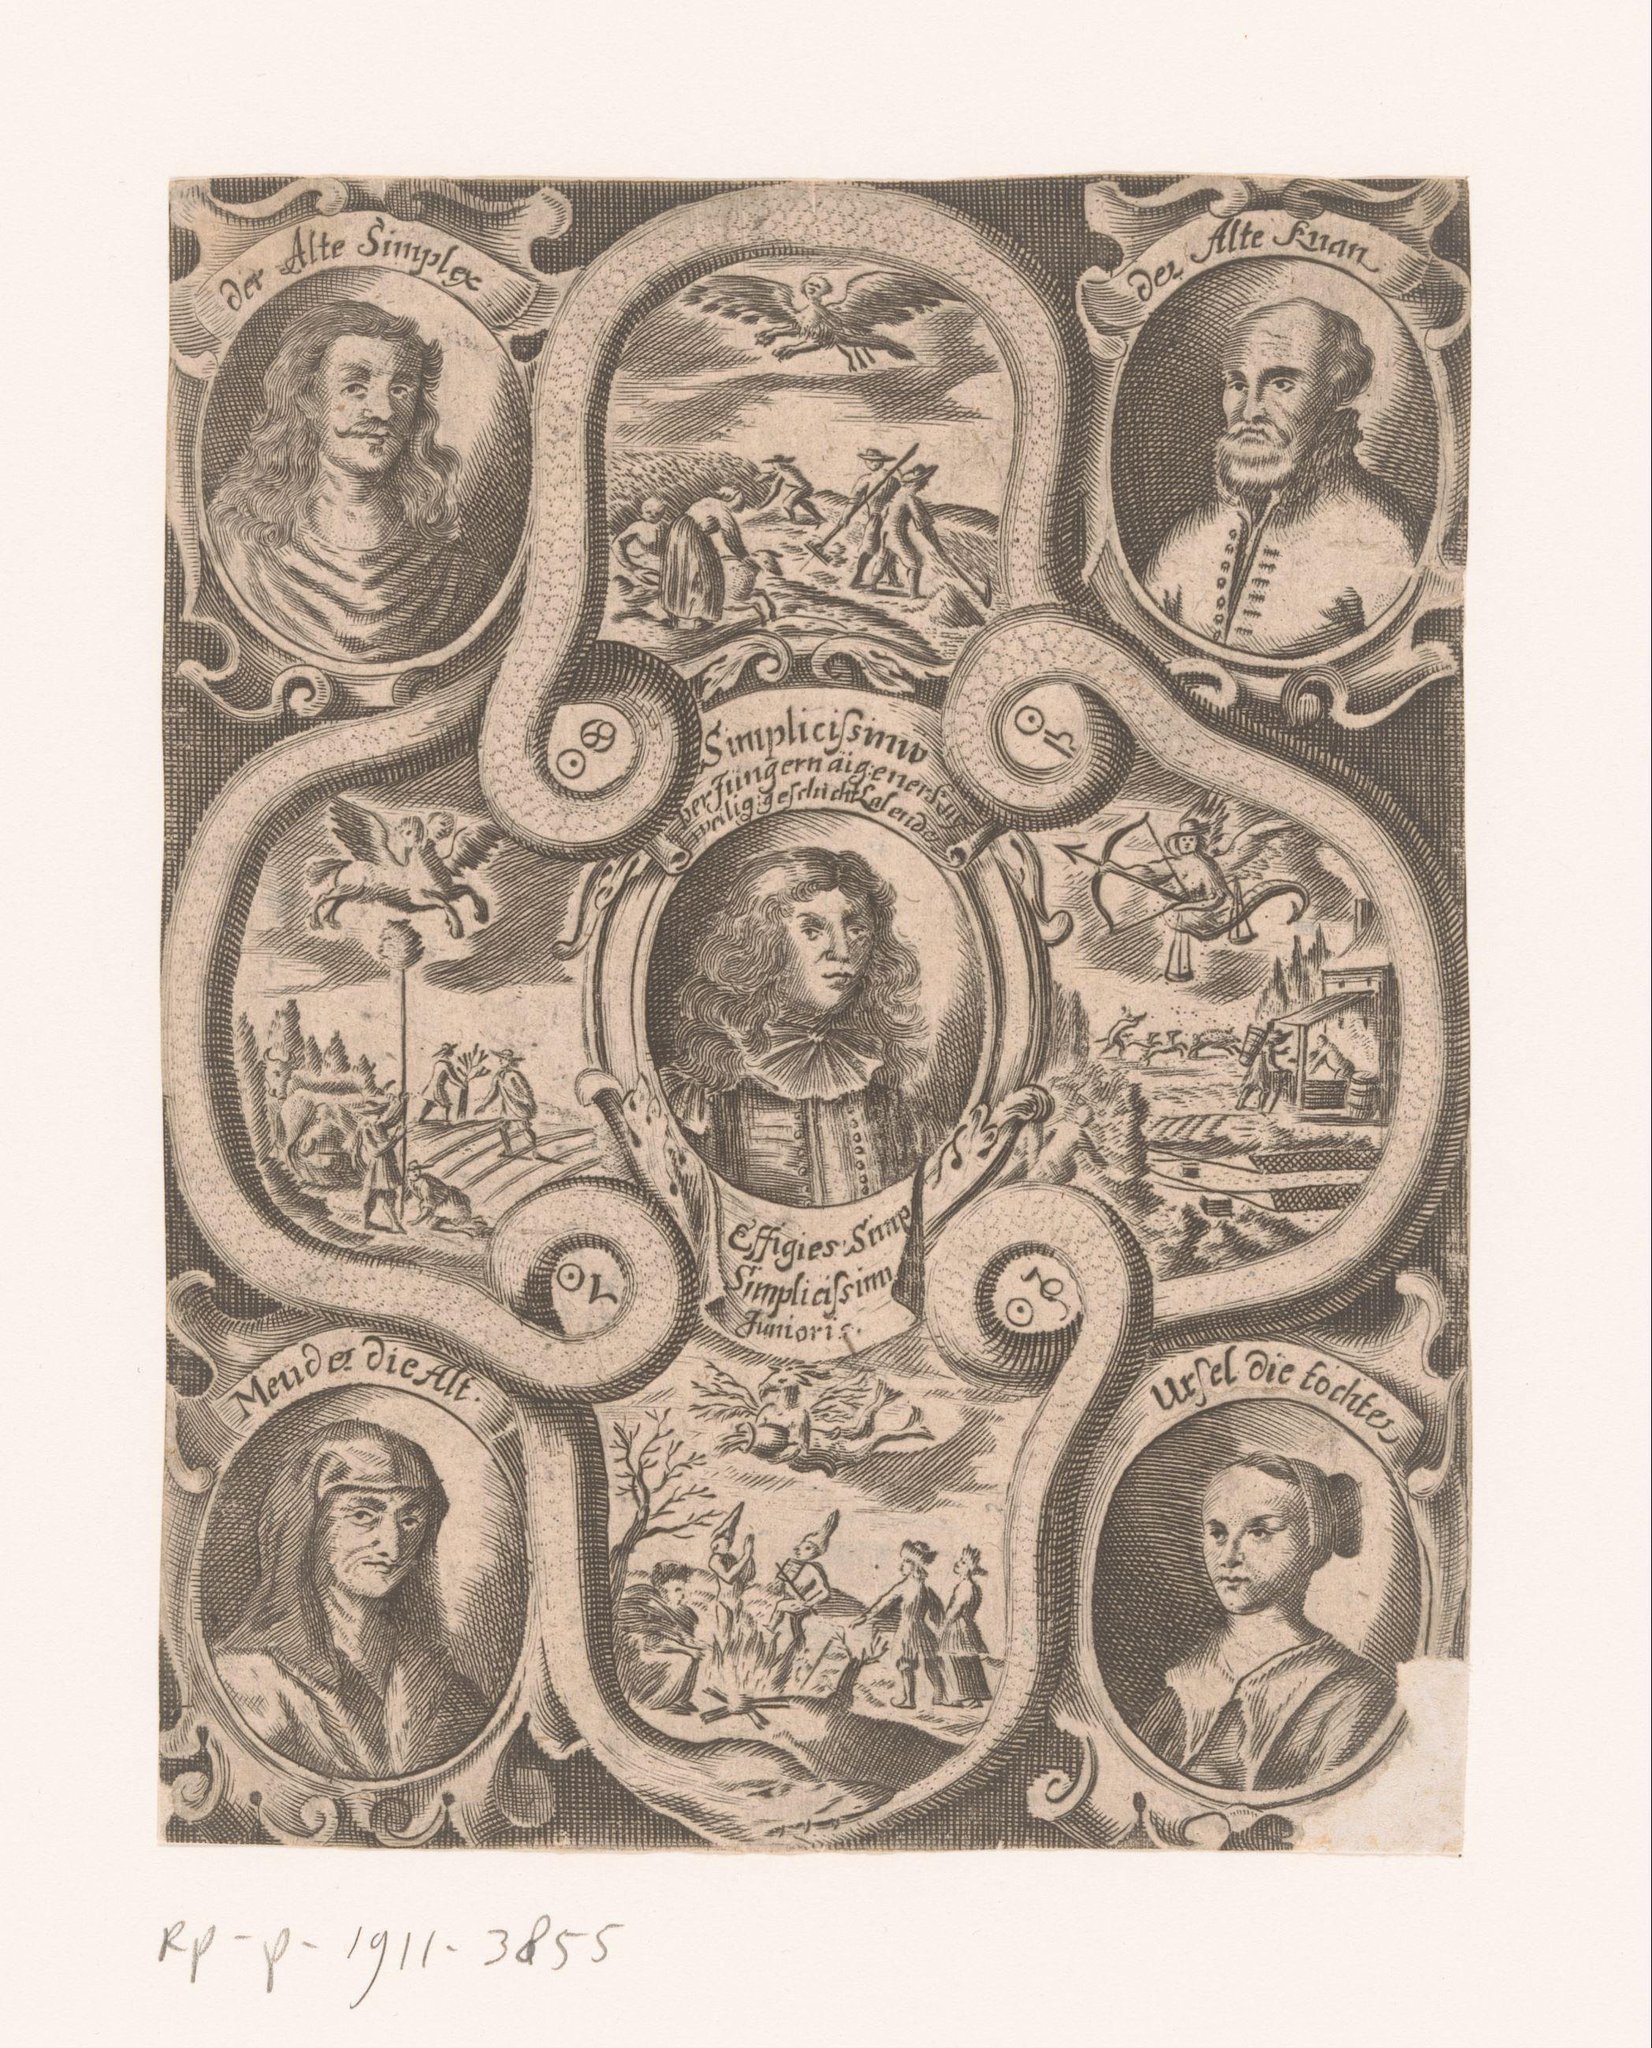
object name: print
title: Portret van een onbekende familie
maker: Anonymous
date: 1600-1699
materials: paper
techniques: etching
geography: germany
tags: historical persons, abstract ideas and concepts (+ emblematical representation of concept)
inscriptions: collector's mark: Lugt 2228